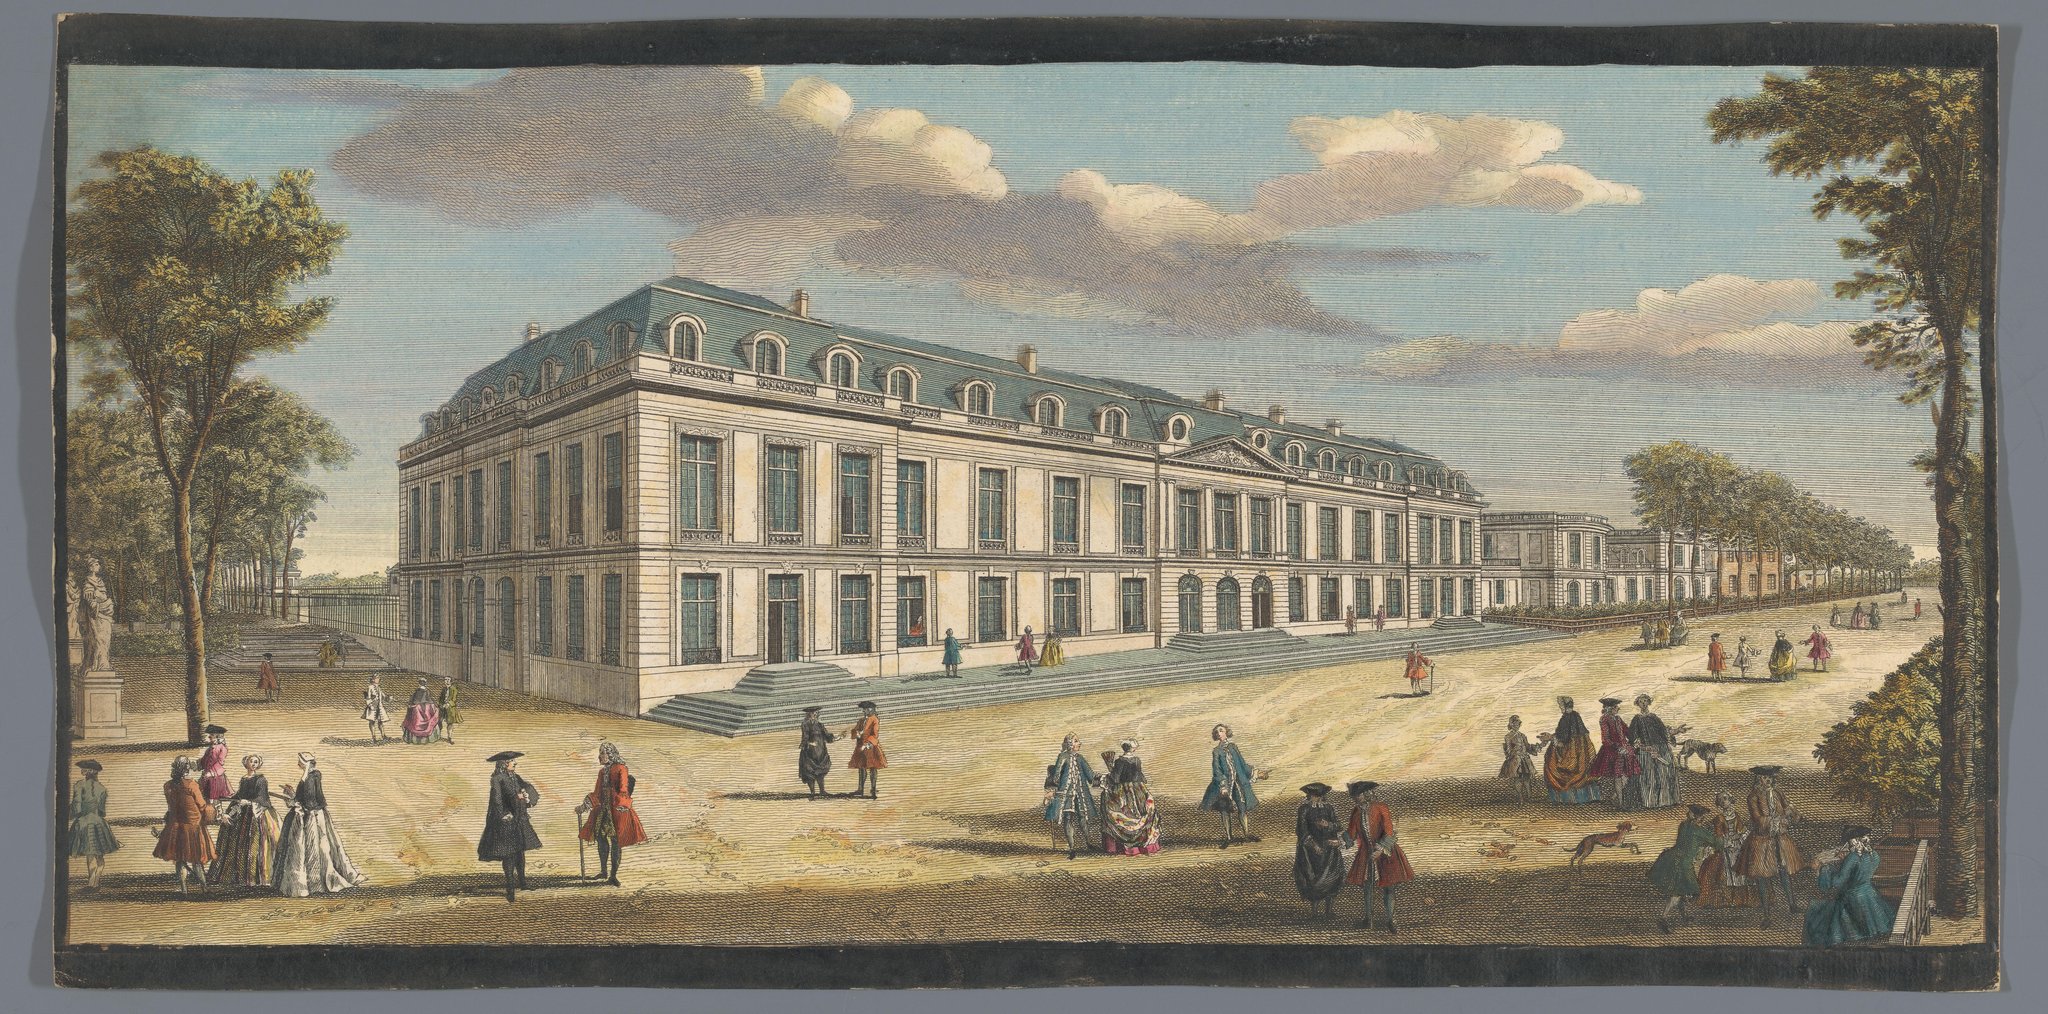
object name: opticaprent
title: A view of the royal Palace of Choisy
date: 1700-1761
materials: cardboard, paper, watercolor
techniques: brush, etching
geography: england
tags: civic architecture; edifices; dwellings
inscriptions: inscription: ‘Fo 24 B4’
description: In de ondermarge twee regels Franse en twee regels Engelse tekst.